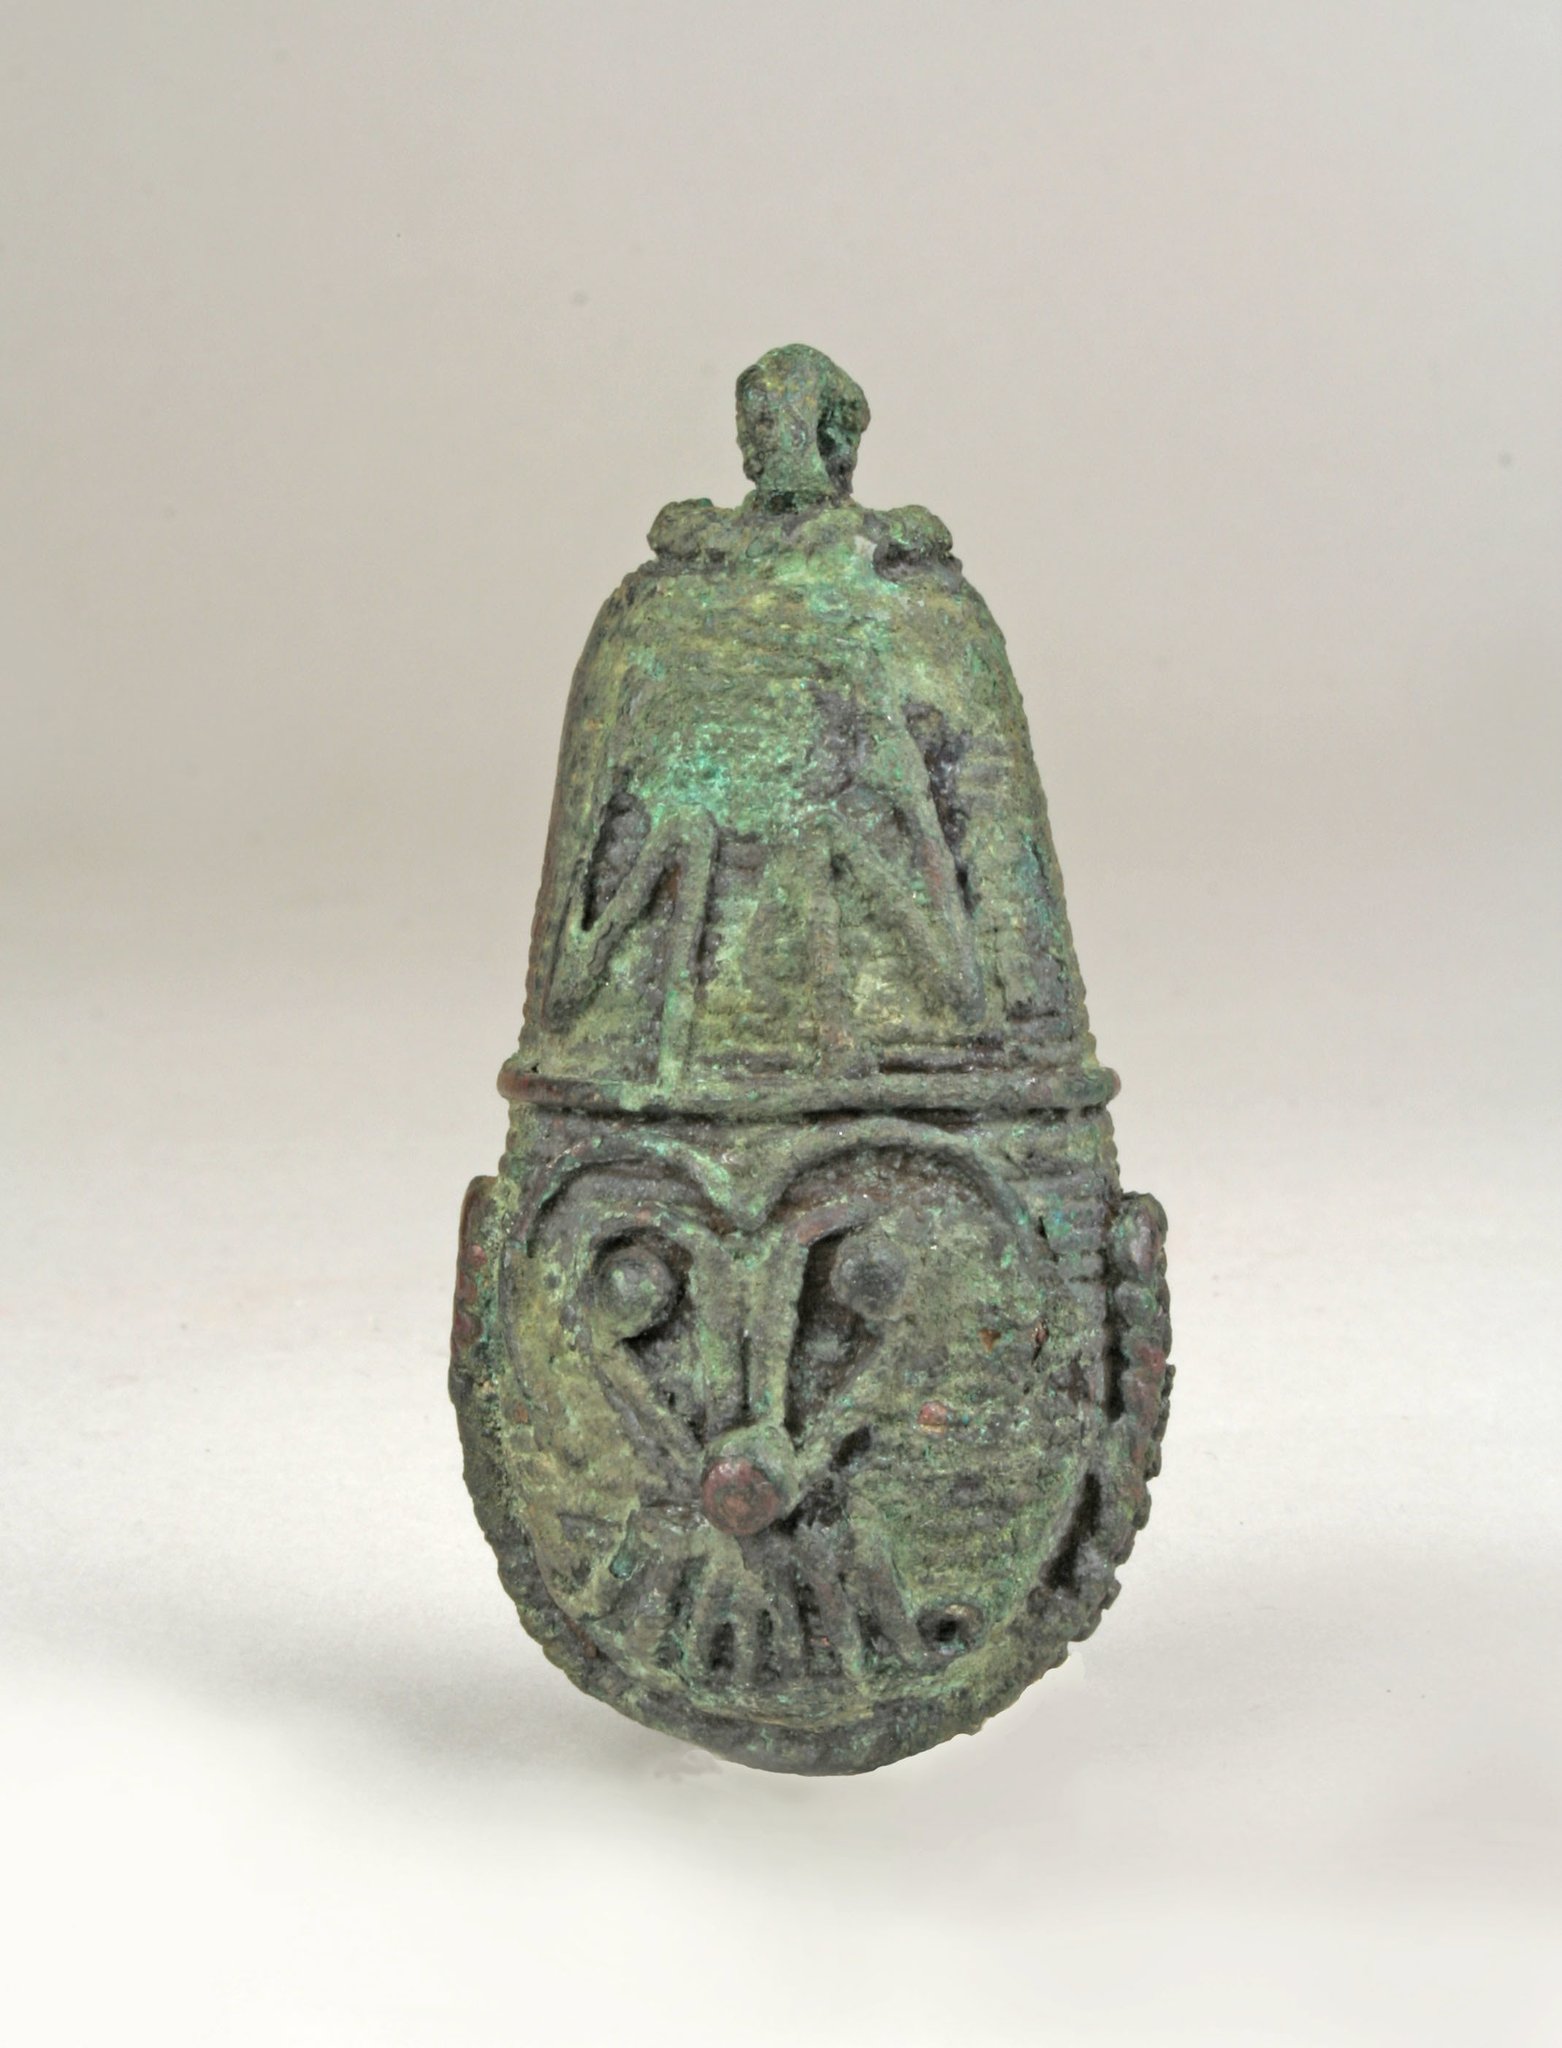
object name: bell fragment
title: Bell with Face (Tlaloc)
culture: mexico, west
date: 1001-1600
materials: copper, copper alloy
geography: mexico